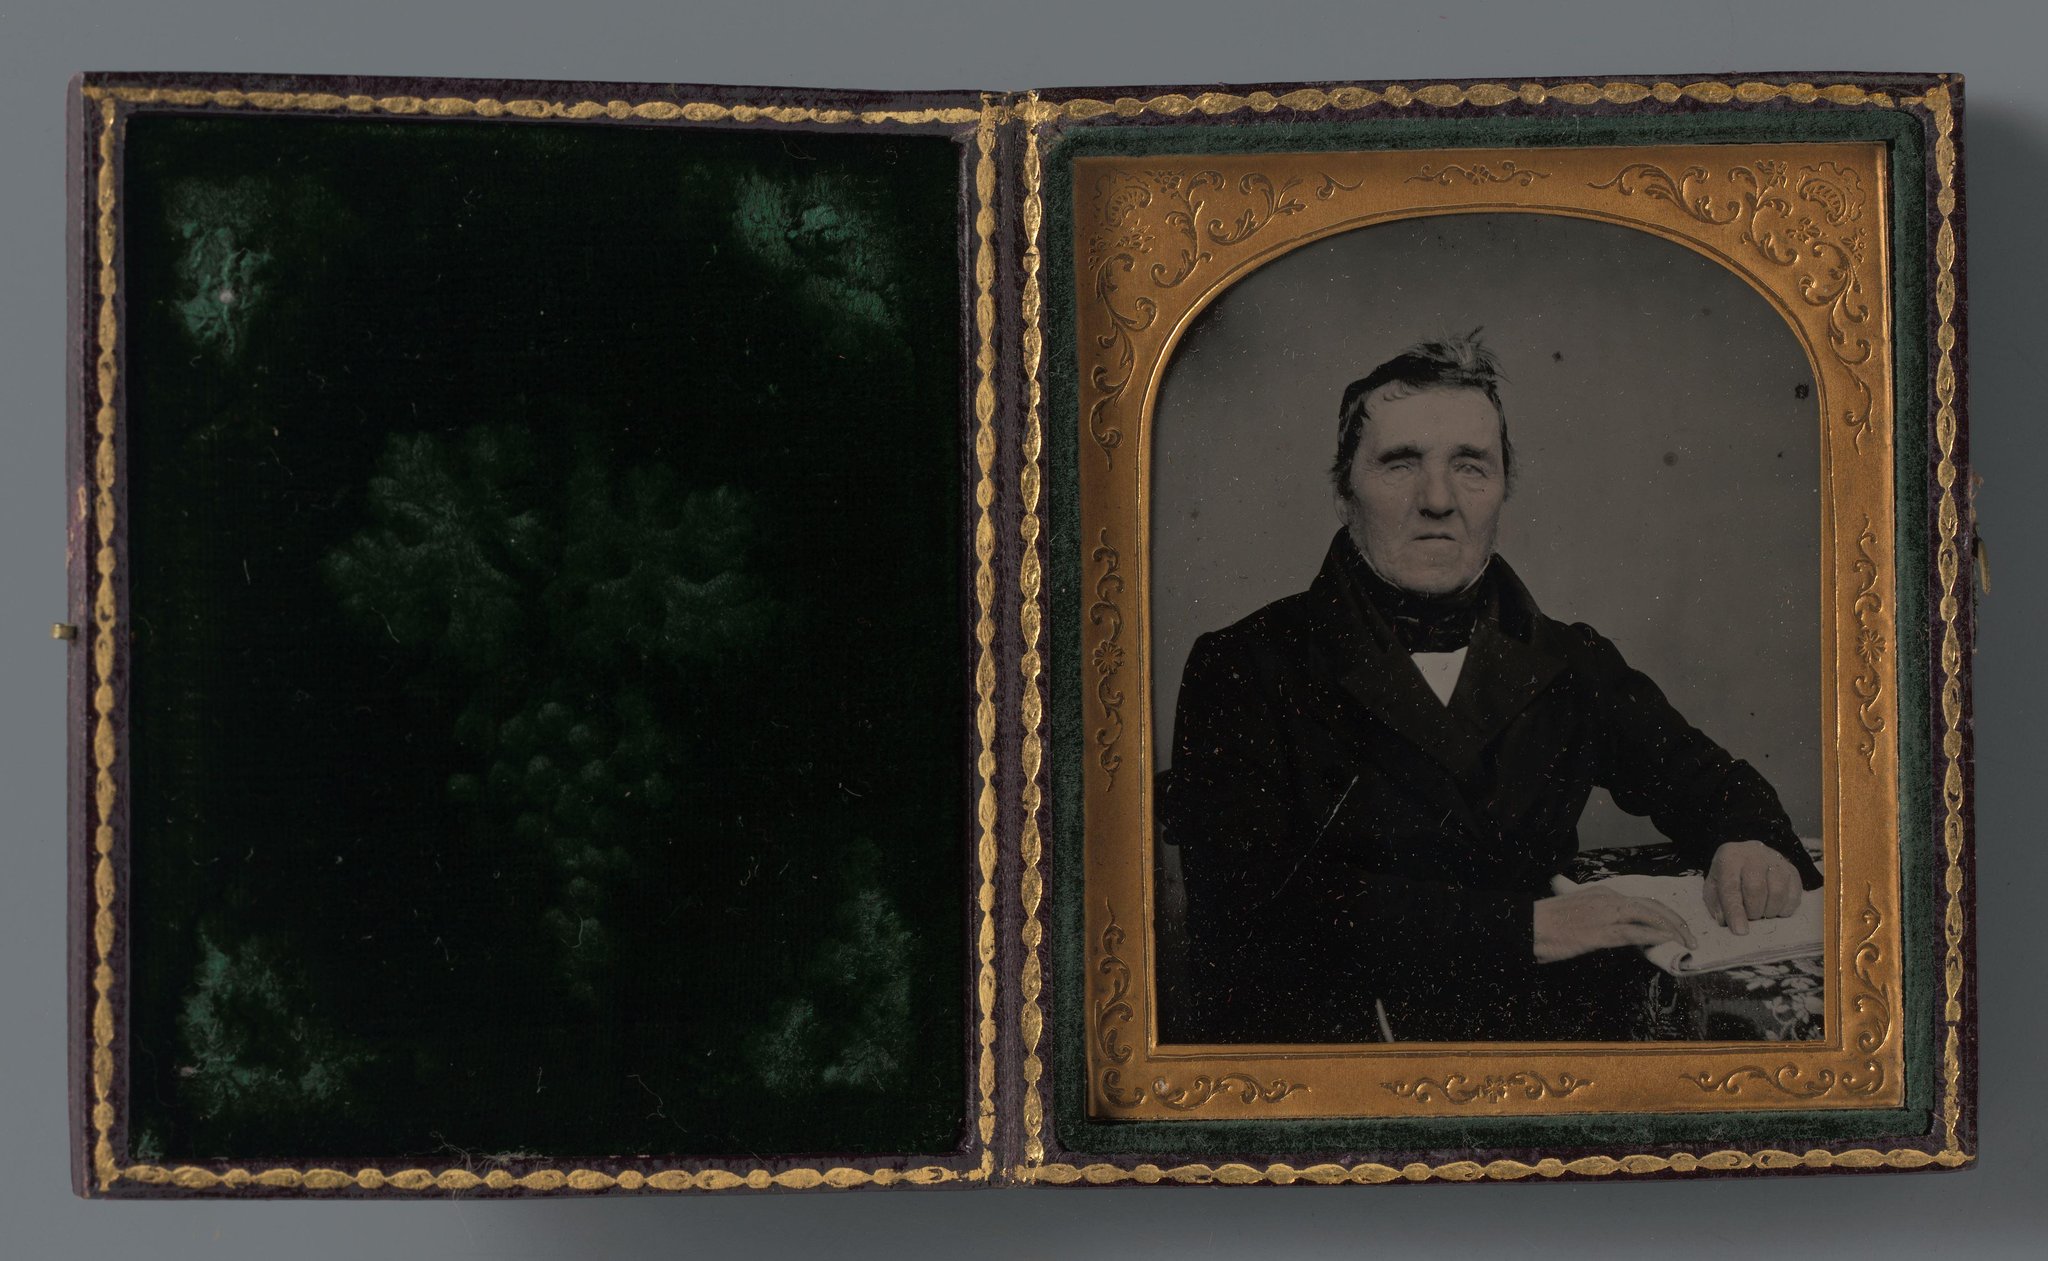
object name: photograph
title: Portret van een onbekende man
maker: Anonymous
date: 1855-1860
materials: copper, glass, leather, metal, velvet, wood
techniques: daguerreotype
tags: historical persons